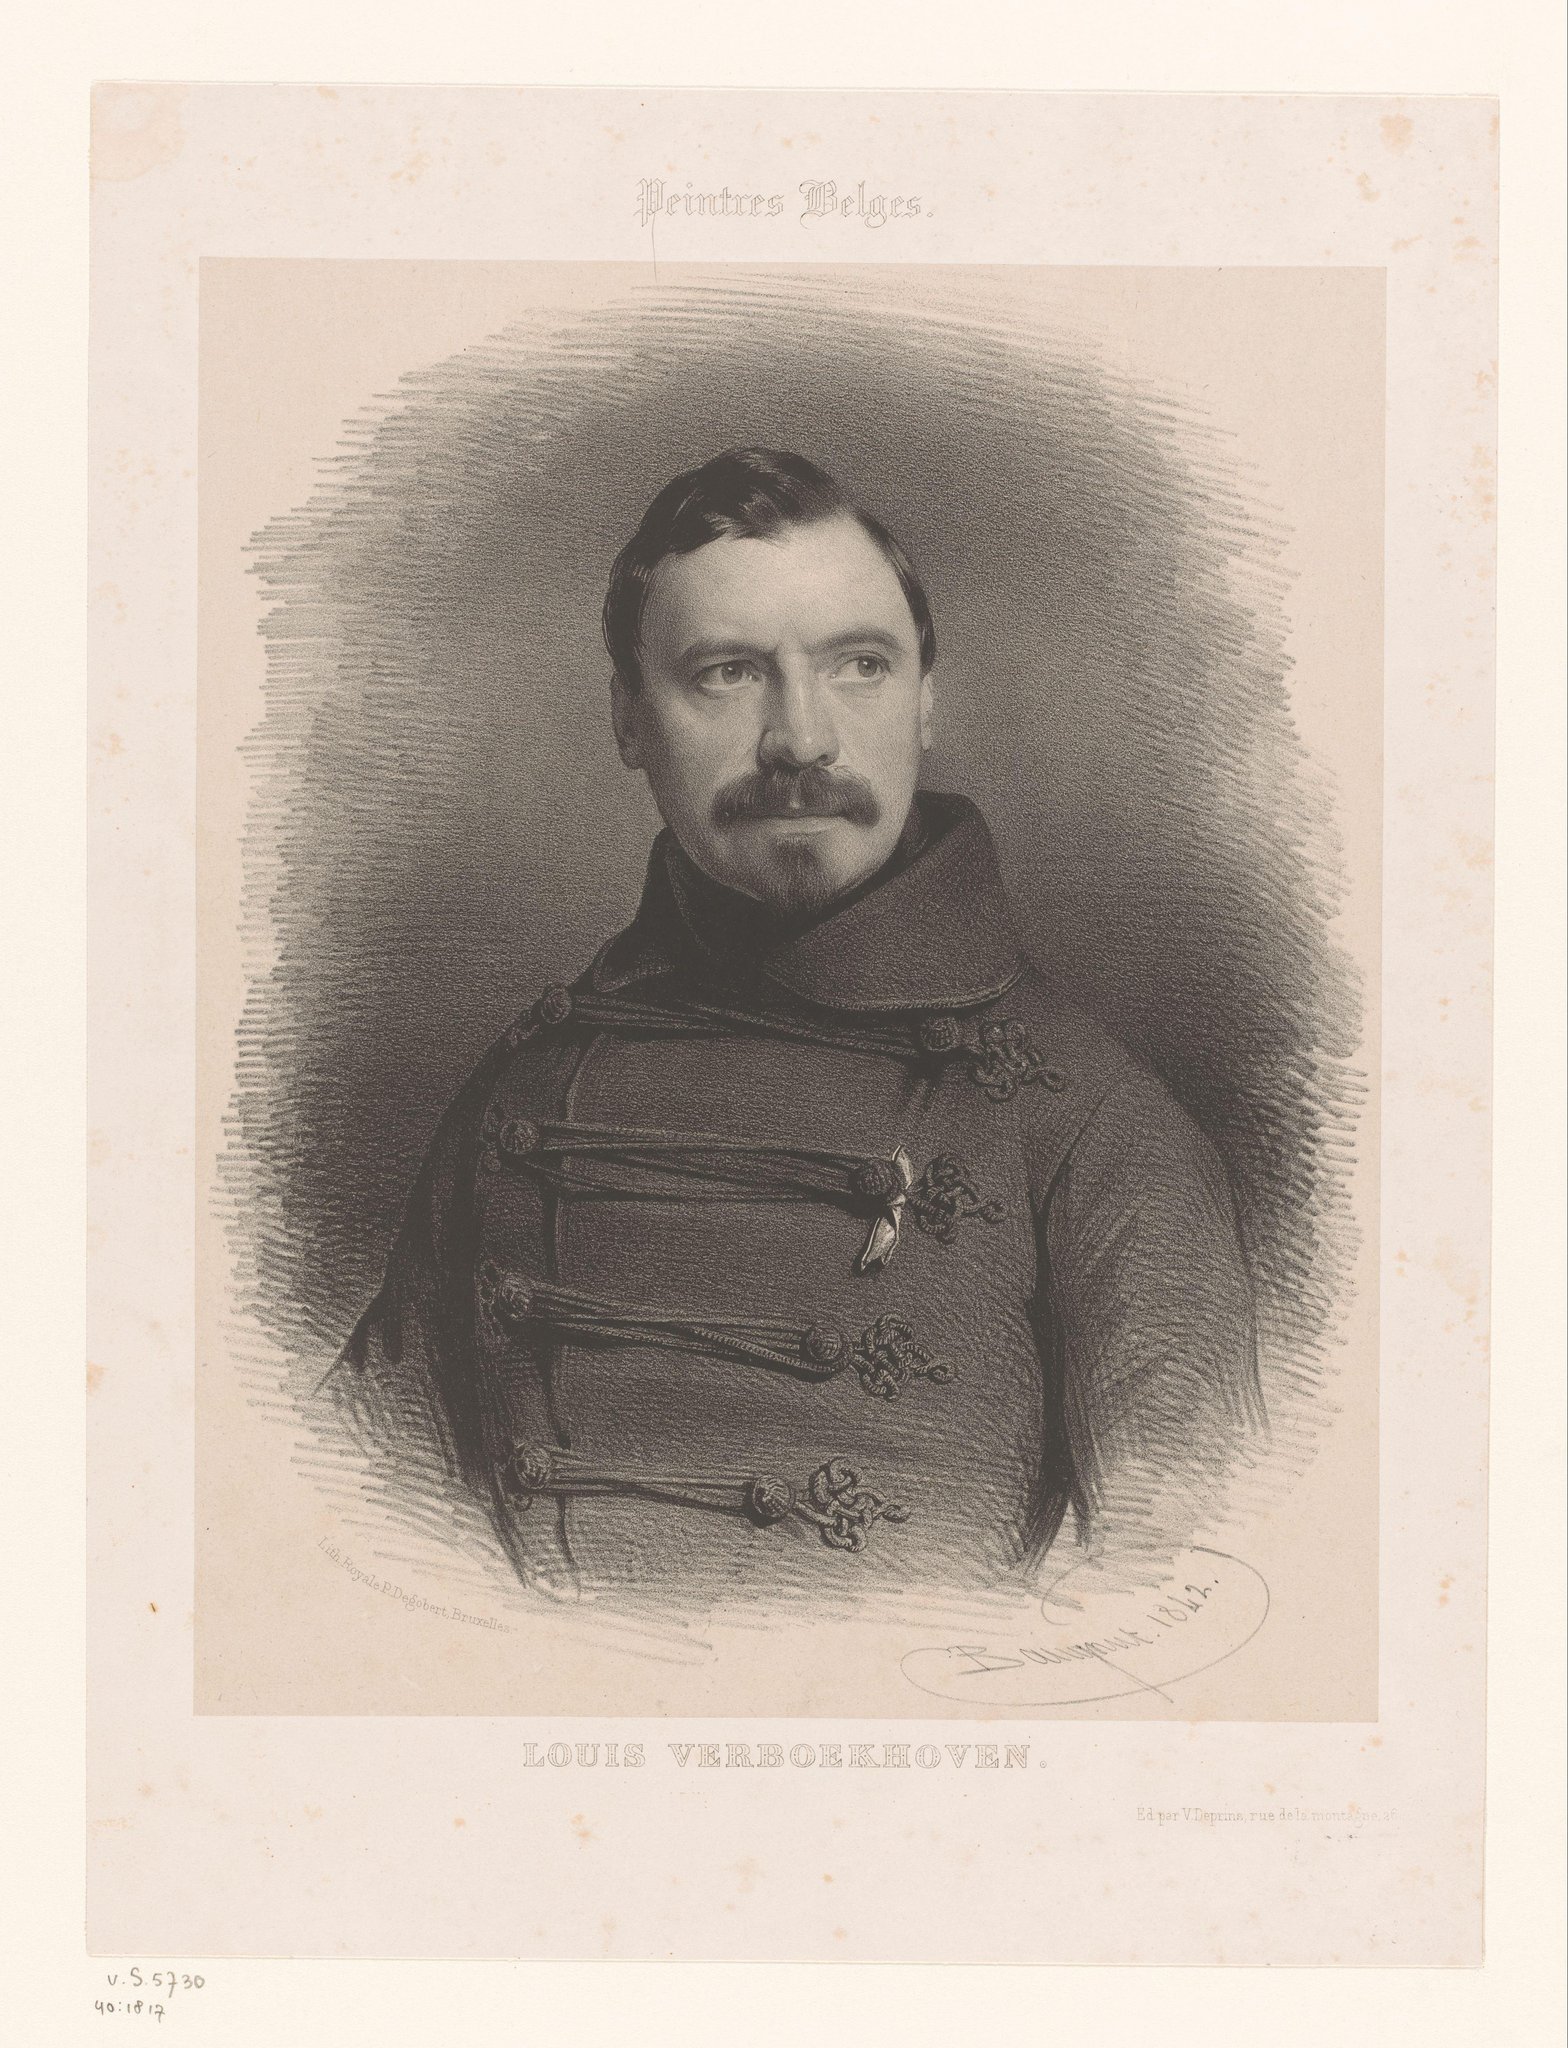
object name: print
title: Peintres Belges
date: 1842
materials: paper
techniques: lithograph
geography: brussels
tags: brussels, draughtsman, charles louis verboeckhoven, moustache, adult man, historical persons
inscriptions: collector's mark: Lugt 2760, collector's mark: Lugt 2228